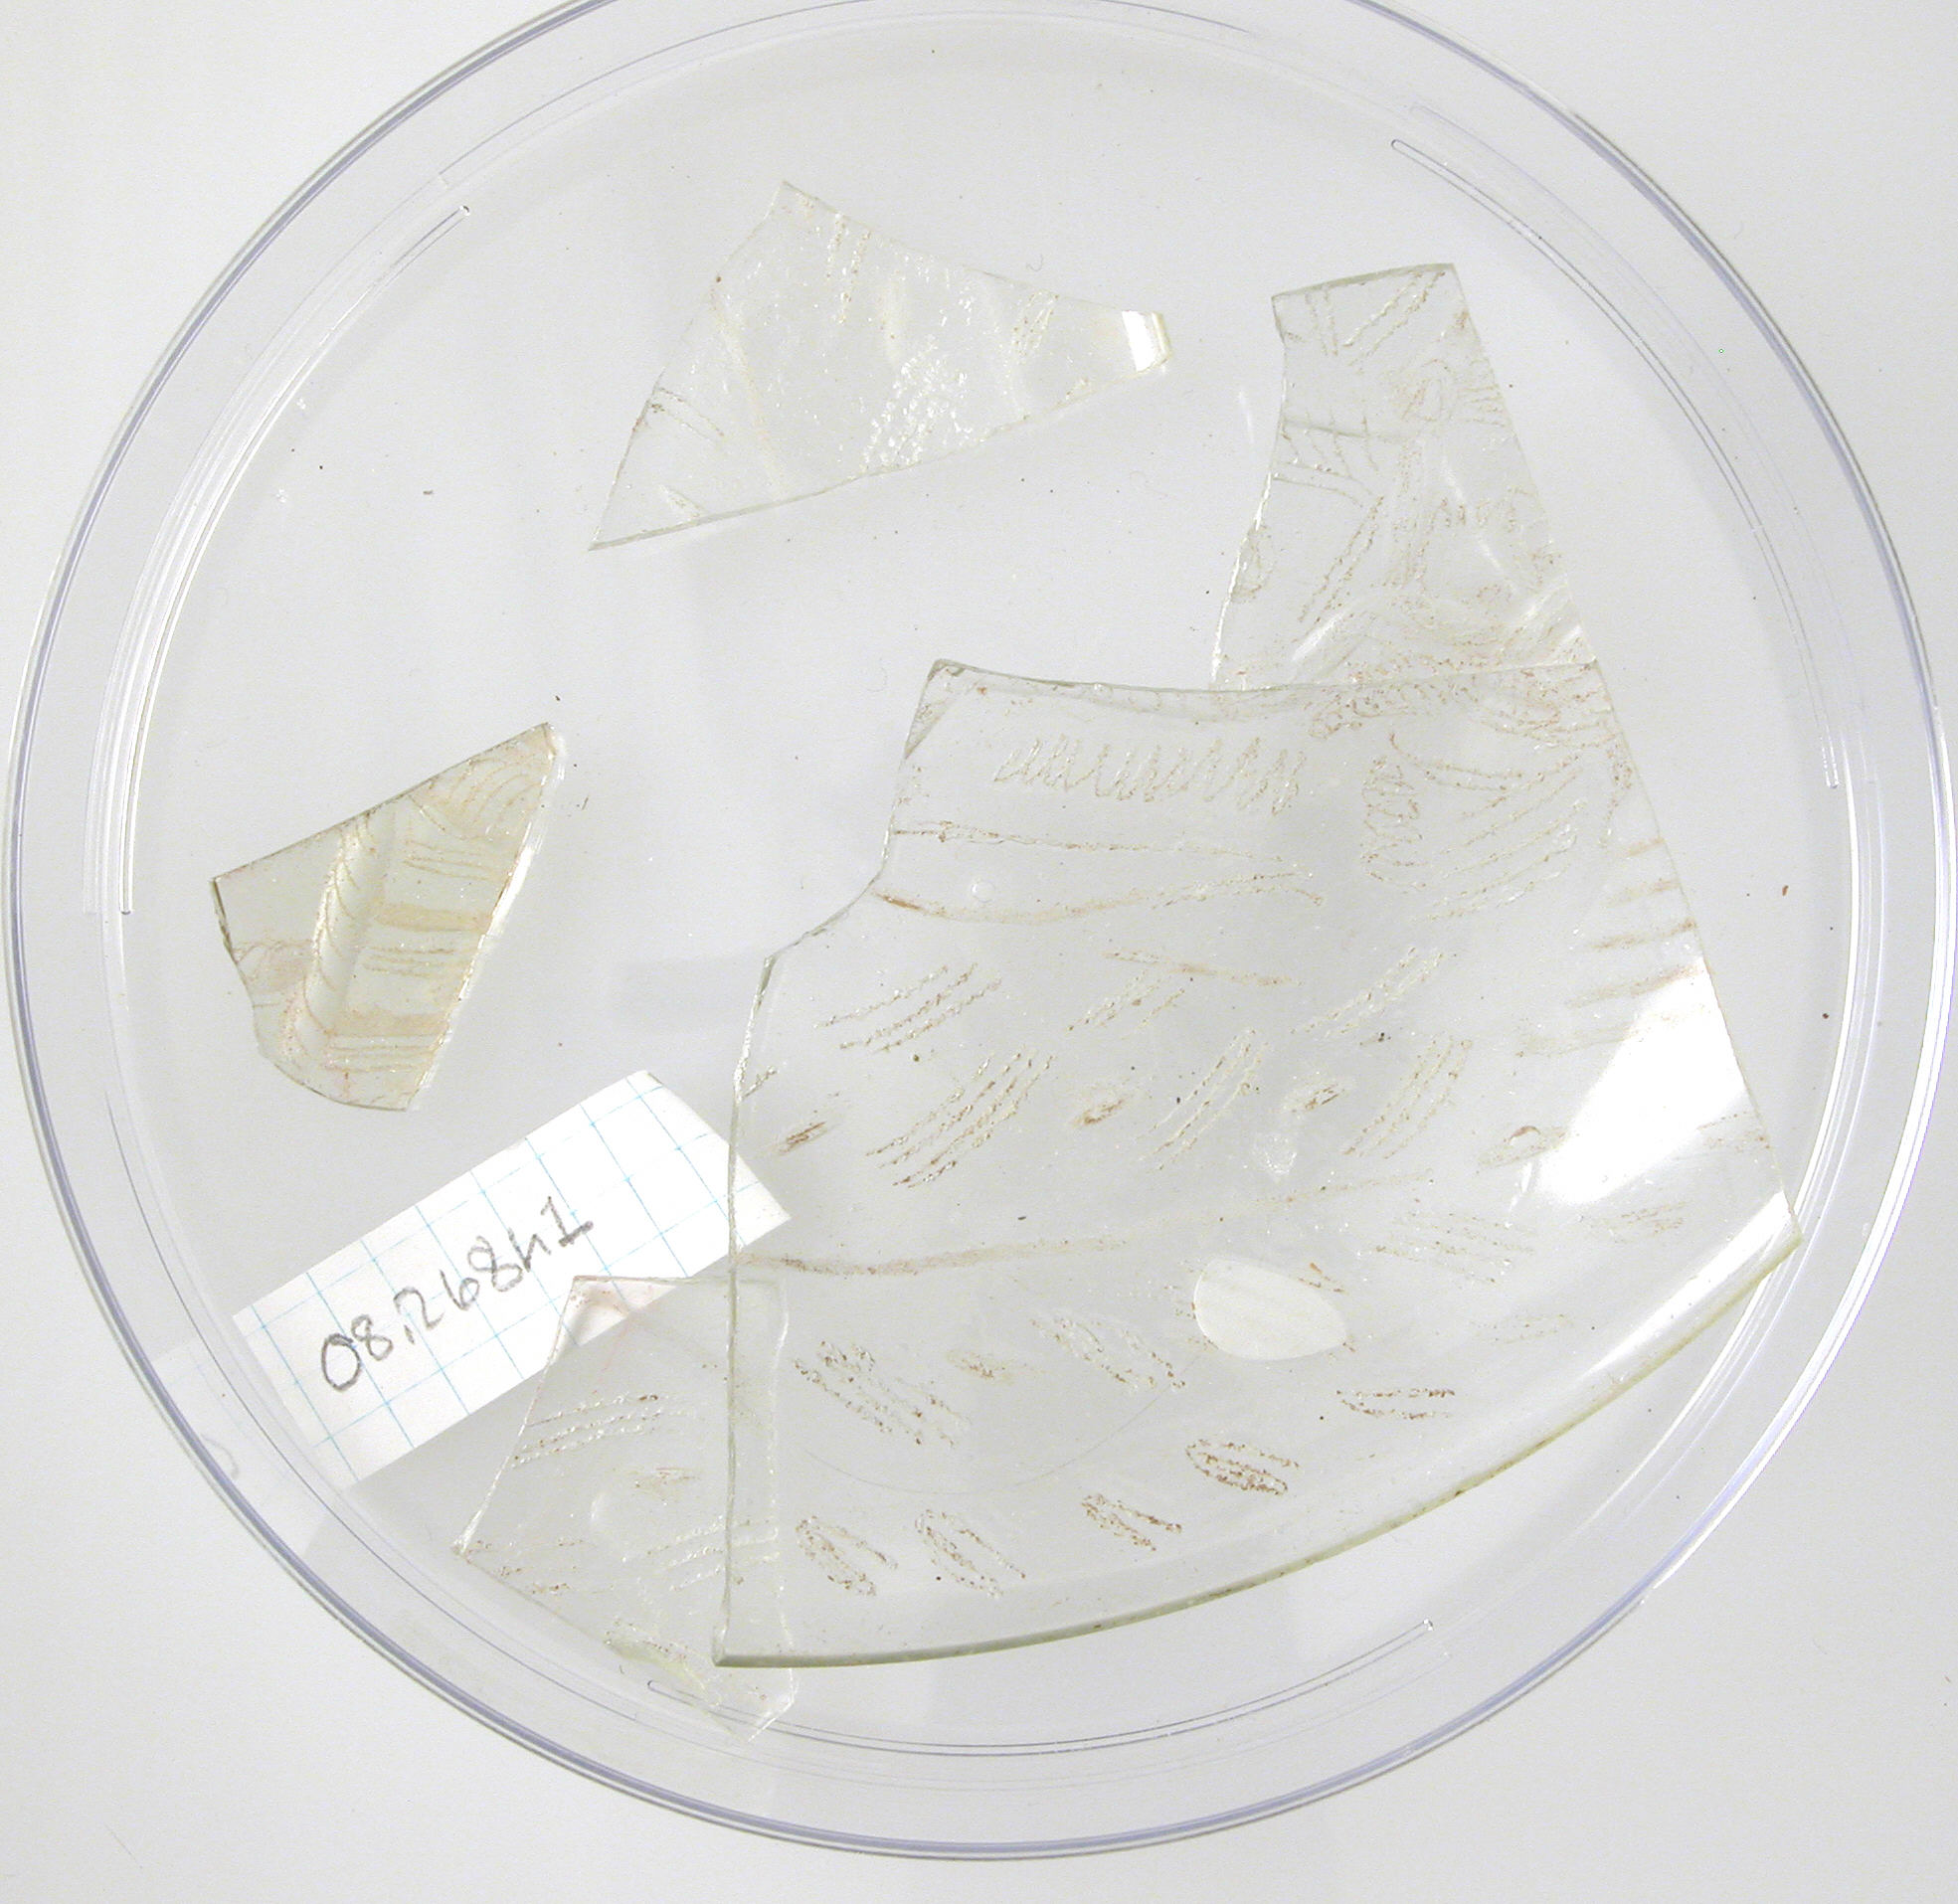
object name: fragment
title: Glass Fragments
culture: coptic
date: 301-433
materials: glass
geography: egypt